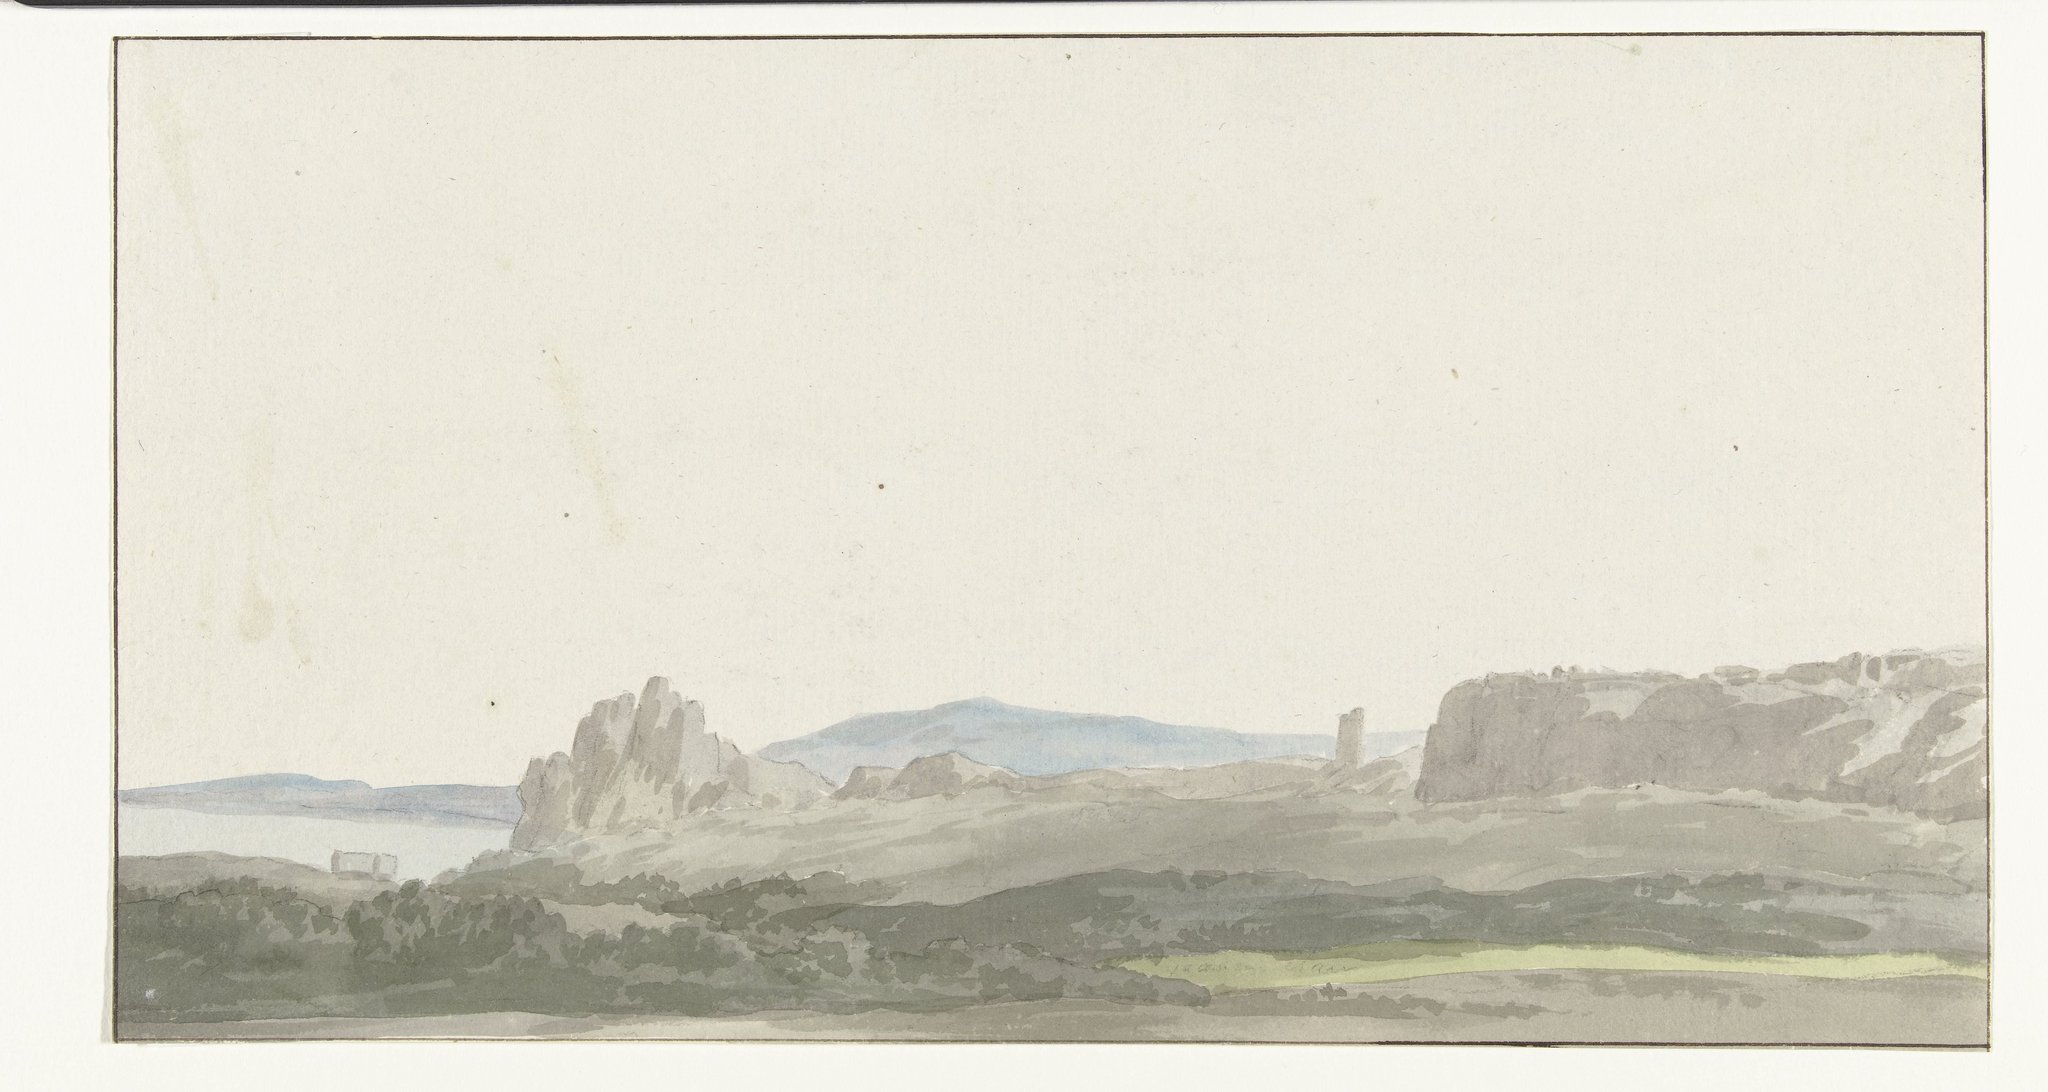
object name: drawing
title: Gezicht op een rots bij de Golf van Tarente in de buurt van Gallipoli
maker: louis ducros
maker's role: draughtsman, print maker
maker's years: 1748-1810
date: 1778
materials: chalk, paper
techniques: brush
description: Tekening uit het album 'Voyage en Italie, en Sicile et à Malte', 1778.